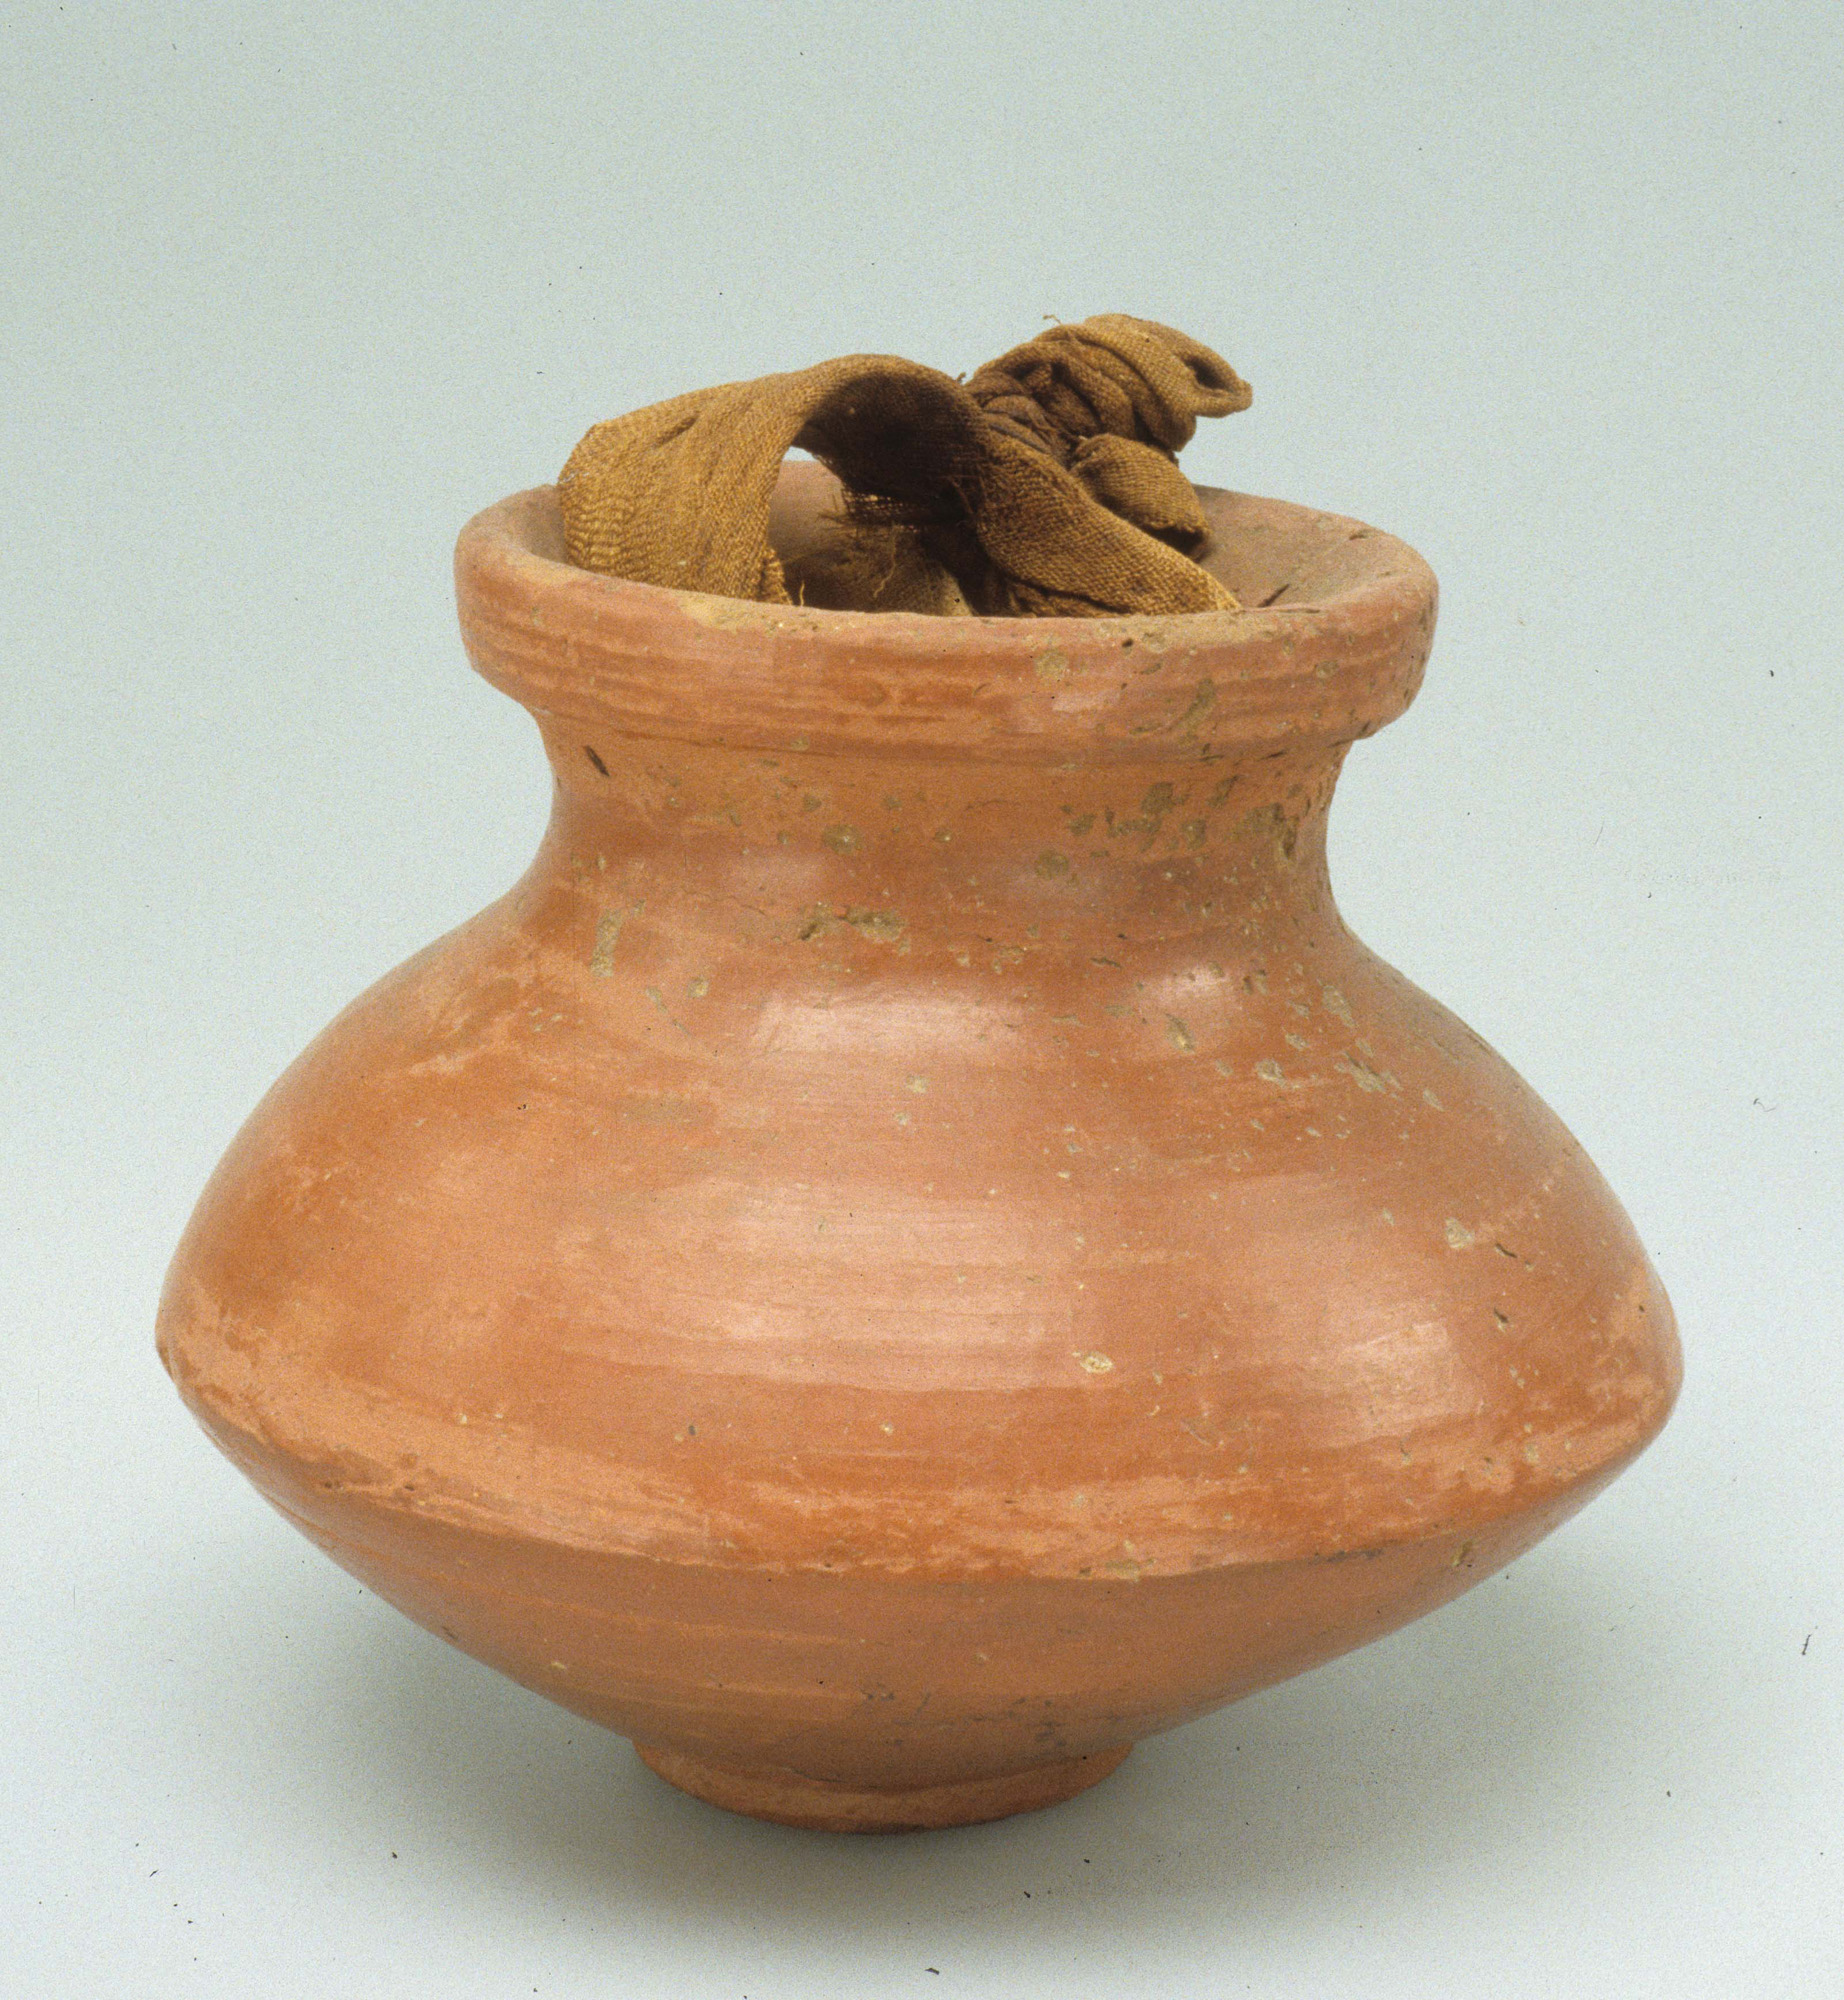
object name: jar, baki, carinated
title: Small Carinated Jar with Cloth Lid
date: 1504-1447 BCE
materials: textile, pottery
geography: egypt